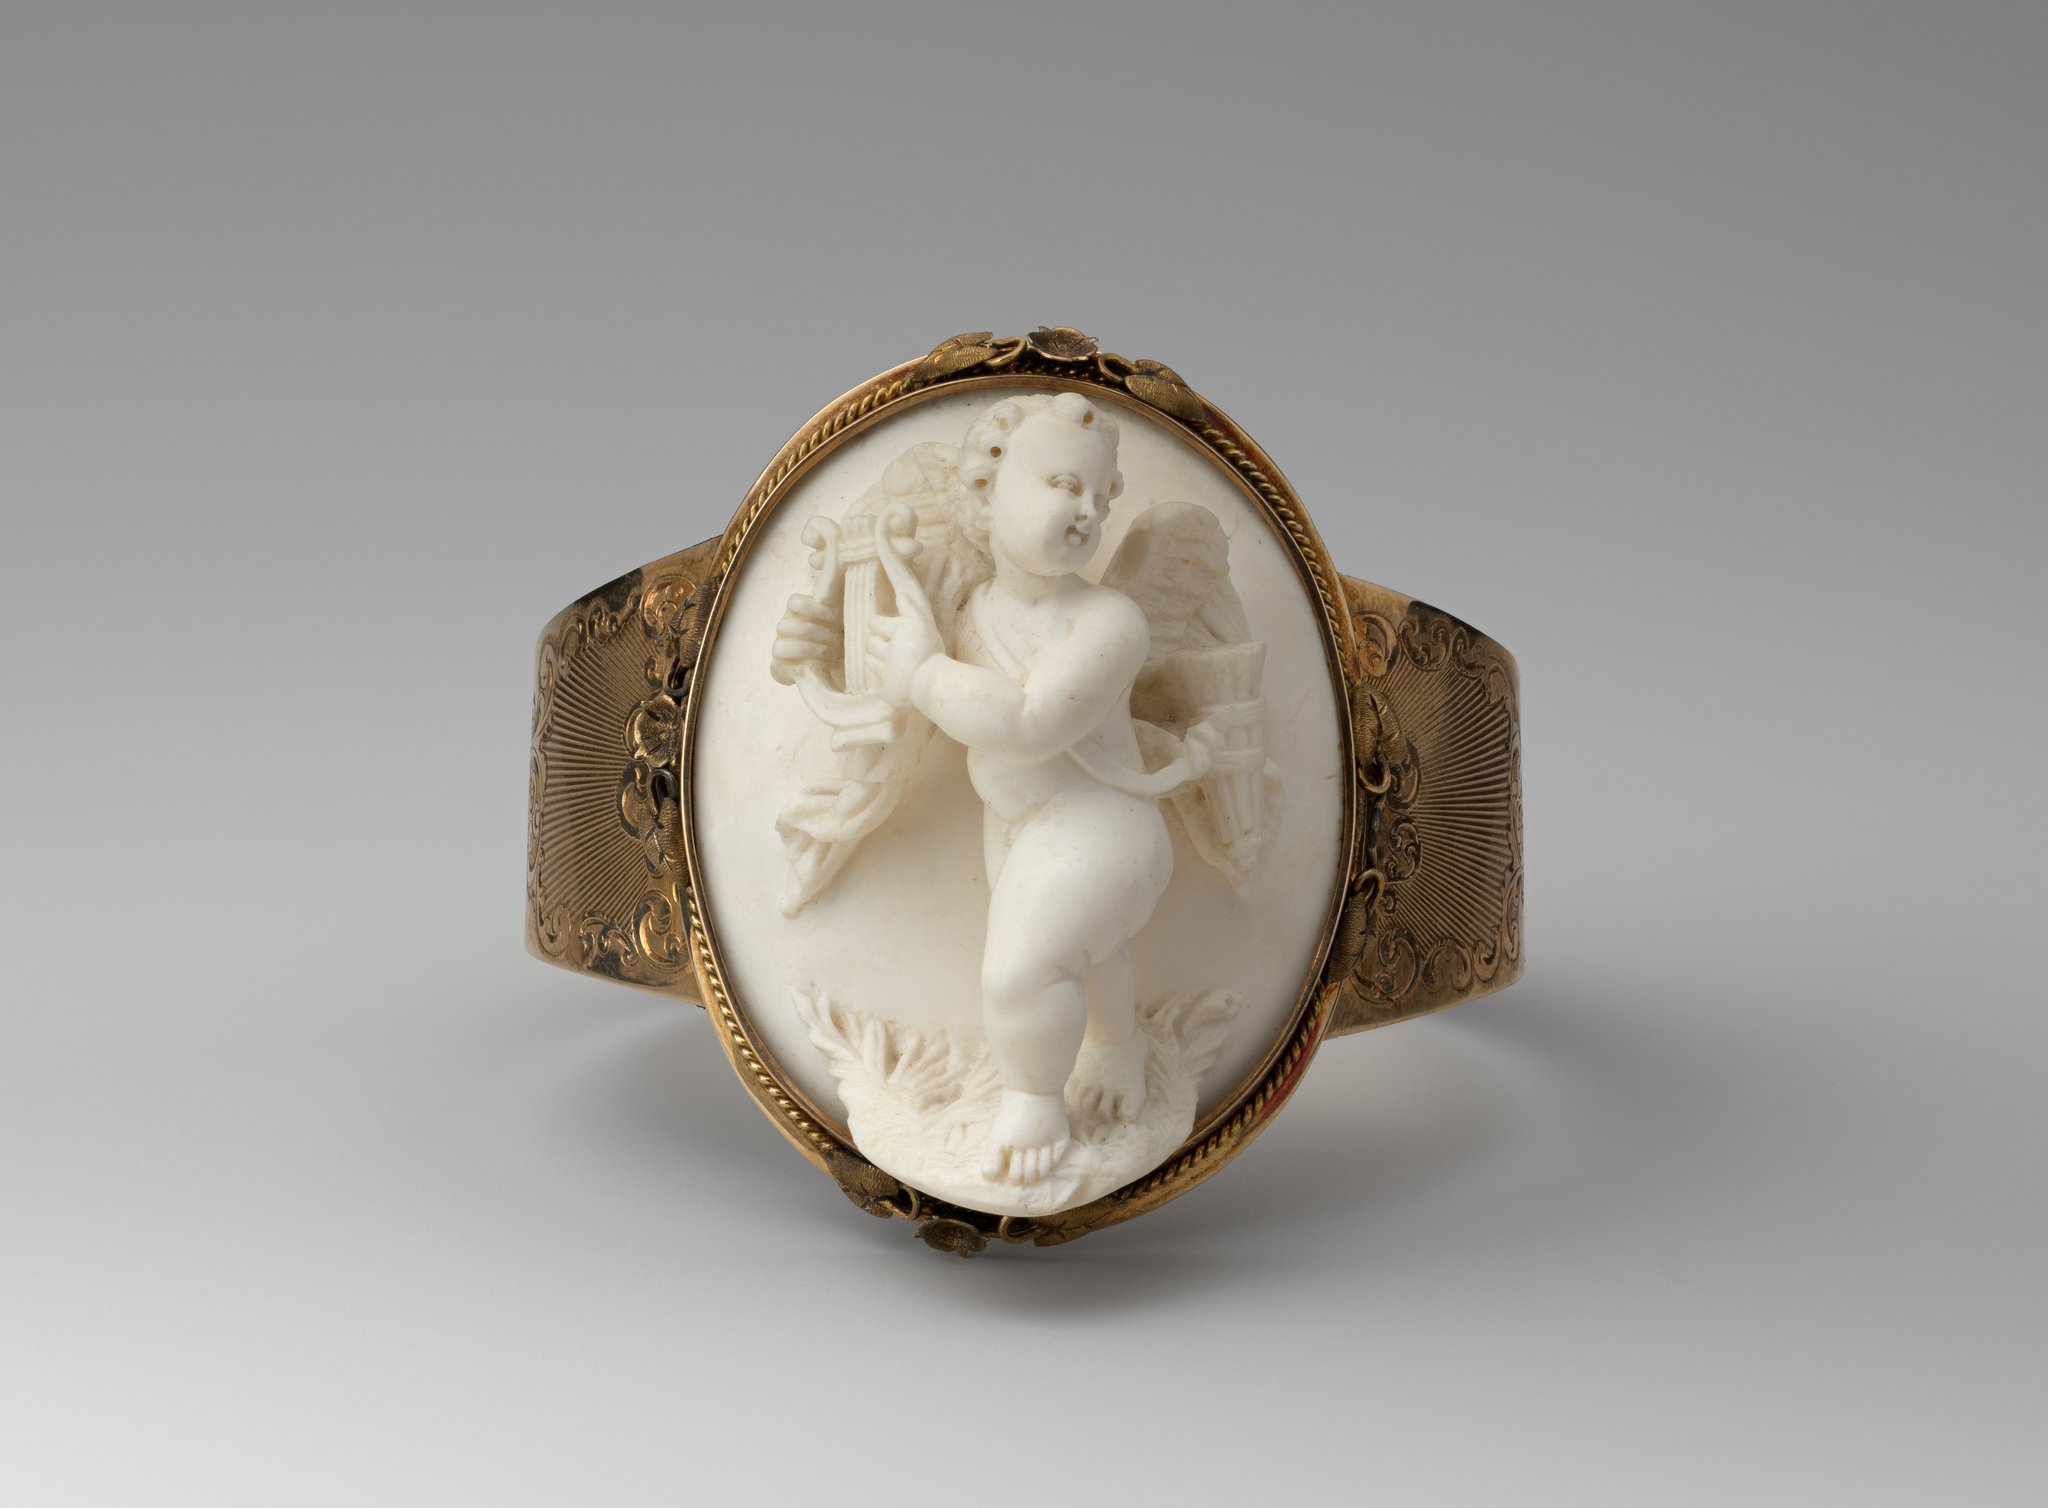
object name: bracelet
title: Bracelet (part of parure)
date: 1840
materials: gold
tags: cupid